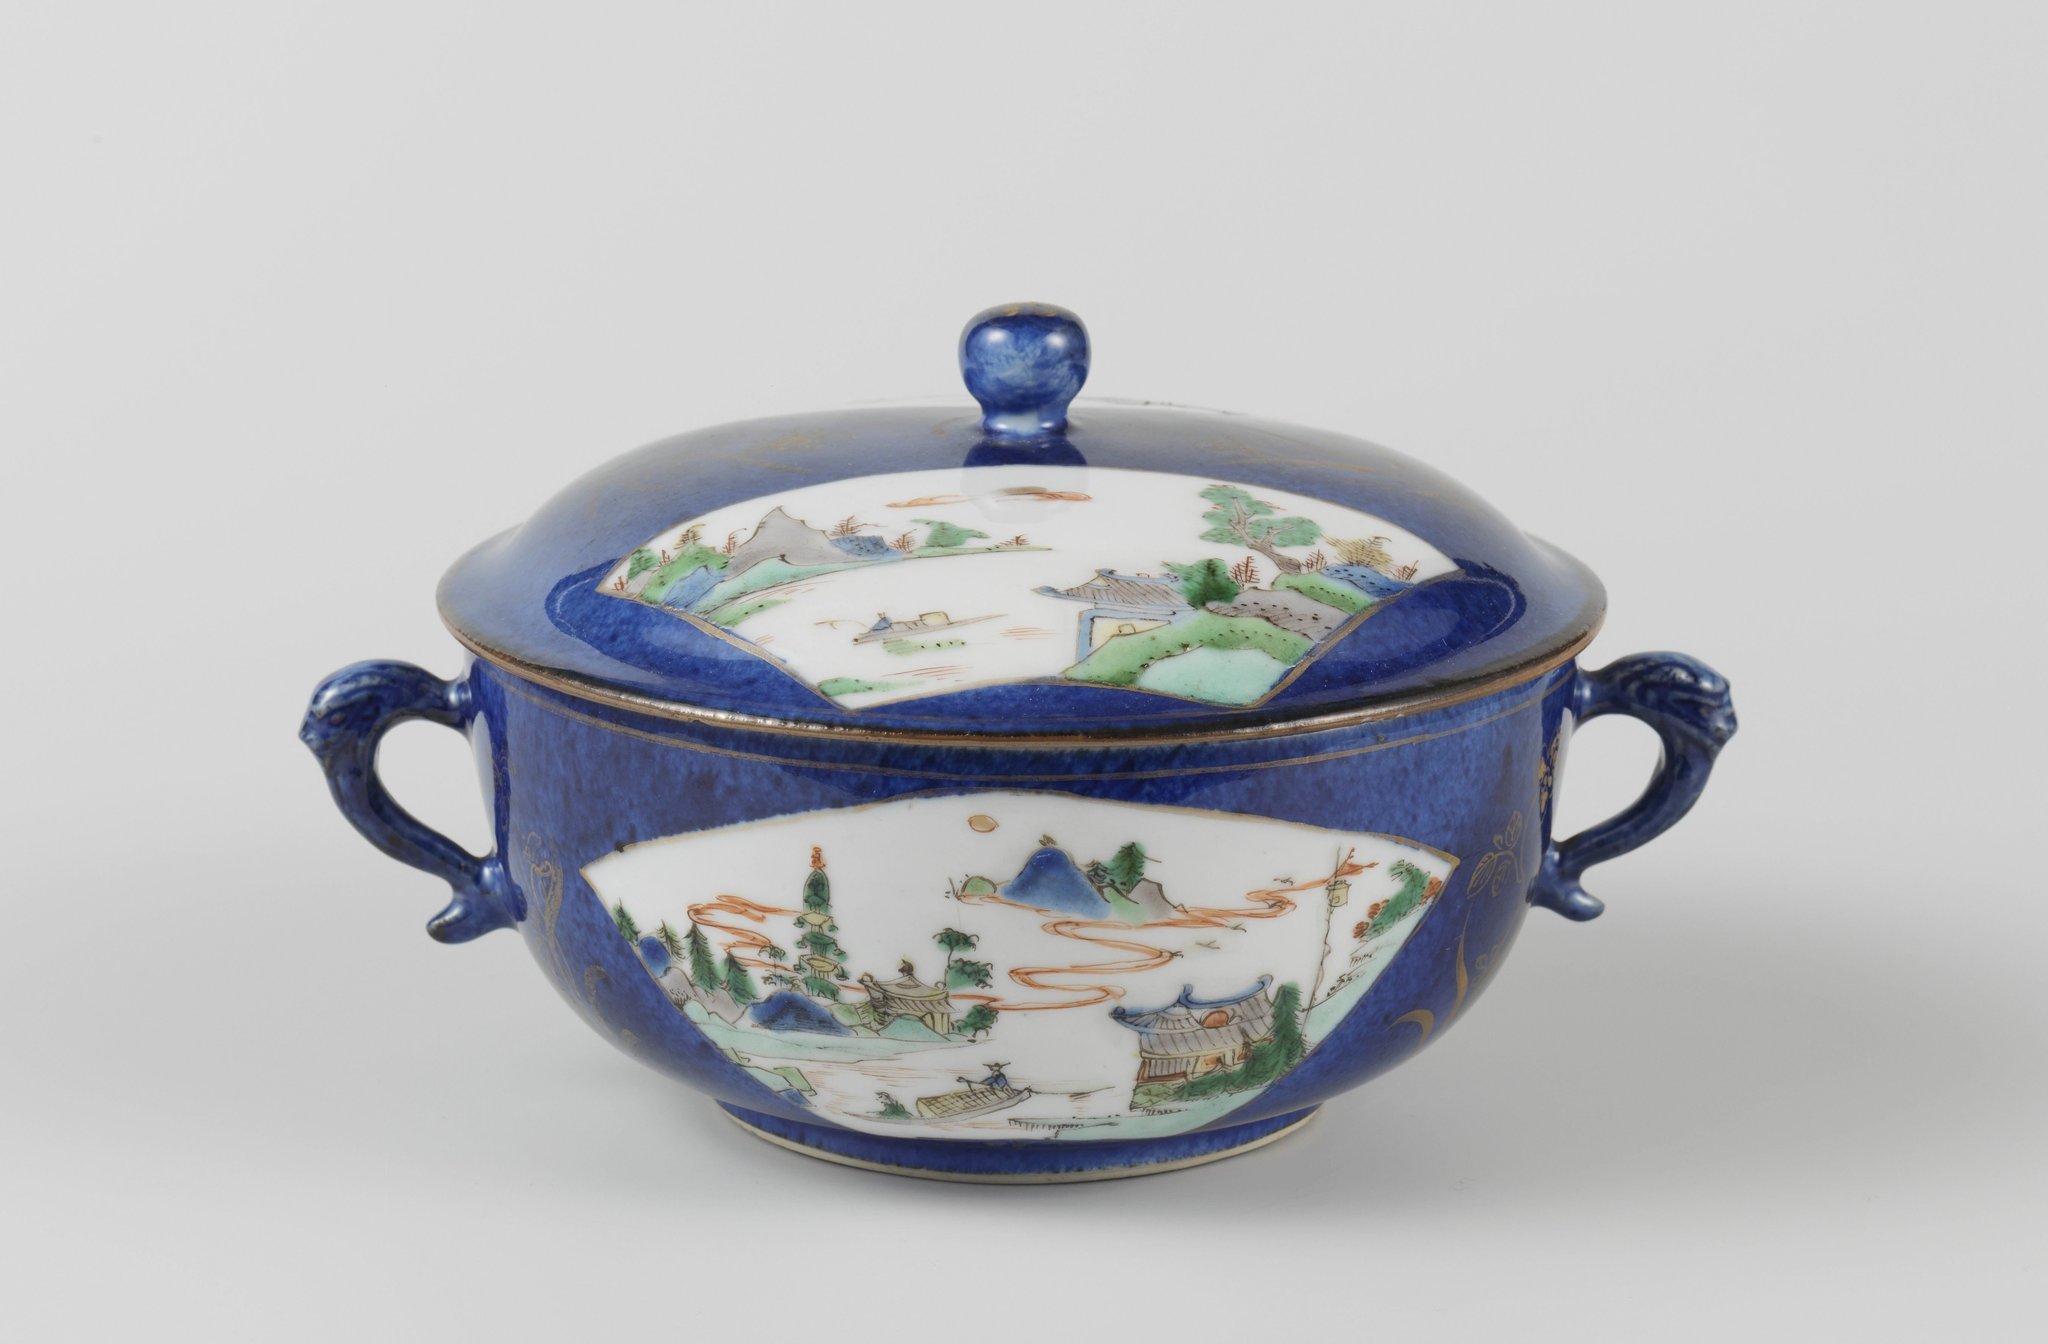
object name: covered bowl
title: Covered bowl with powder blue and river landscapes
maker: Anonymous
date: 1700-1720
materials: cobalt, glaze, gold, paint, porcelain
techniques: firing, gilding, turning, vitrification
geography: china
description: AK-NM-6360 Twee terrines • Bleu poudré-porselein met verte • Onderdeel van Royers porseleincollectie • Mogelijk afkomstig van Susanna Louise Huygens • Gepubliceerd: Jörg 1997, nr. 157; Jörg 2011, nr. 97. Voor enkele opmerkingen over de vorm van deze terrine, zie de toelichting bij Ak-NM-6921. Het is interessant dat zich in de collectie van August de Sterke in Dresden een terrine bevindt met precies dezelfde vorm, maar met een licht café au lait glazuur (en ovale velden in plaats van waaiervormige velden). De terrine komt voor in de inventaris van 1721 [Reichel 1990, nr. 75]. Door de overeenkomst ontstaat het idee dat de poudré en café au lait achtergrond glazuren tot op zekere hoogte één groep vormden in deze periode. Susanna Louise Huygens, van wie Royer in 1786 veel porselein overnam, had, volgens haar inboedelbeschrijving ‘Twee kommen met dekzels en oiren, hoog blauw en bond, met waijer compartimenten, waarin gecoulerde landschappen’. ‘Hoogblauw en bond’ was de manier waarop in haar boedel bleu poudré met verte werd omschreven. In de waterlandschapjes komt blauwe email voor – een reden deze terrines iets later te dateren dan bijvoorbeeld AK-NM-6265 en AK-NM-6367. Aan het schilderwerk is te zien dat dit met grote vaart is uitgevoerd. Daar verleent de voorstelling een prettige directheid, maar ik heb toch het idee dat dit wat later gedateerd moet worden, in een periode toen de druk om goedkoop en concurrerend te leveren groter was dan bij de introductie van een dit type decoratie. Het snelle schilderwerk leidt soms tot ogenschijnlijk geaquarelleerde boomgroepen. Prachtig. Bronnen: Friedrich Reichel, Farbige Glasuren auf Porzellan: China 7. bis. 18. Jahrhundert, Dresden, 1990. Christiaan J.A. Jörg, Chinese ceramics in the collection of the Rijksmuseum, Amsterdam: the Ming and Qing dynasties, Londen, 1997. Christiaan J.A. Jörg, Famille verte: Chinese porcelain in green enamels, Groningen, 2011.